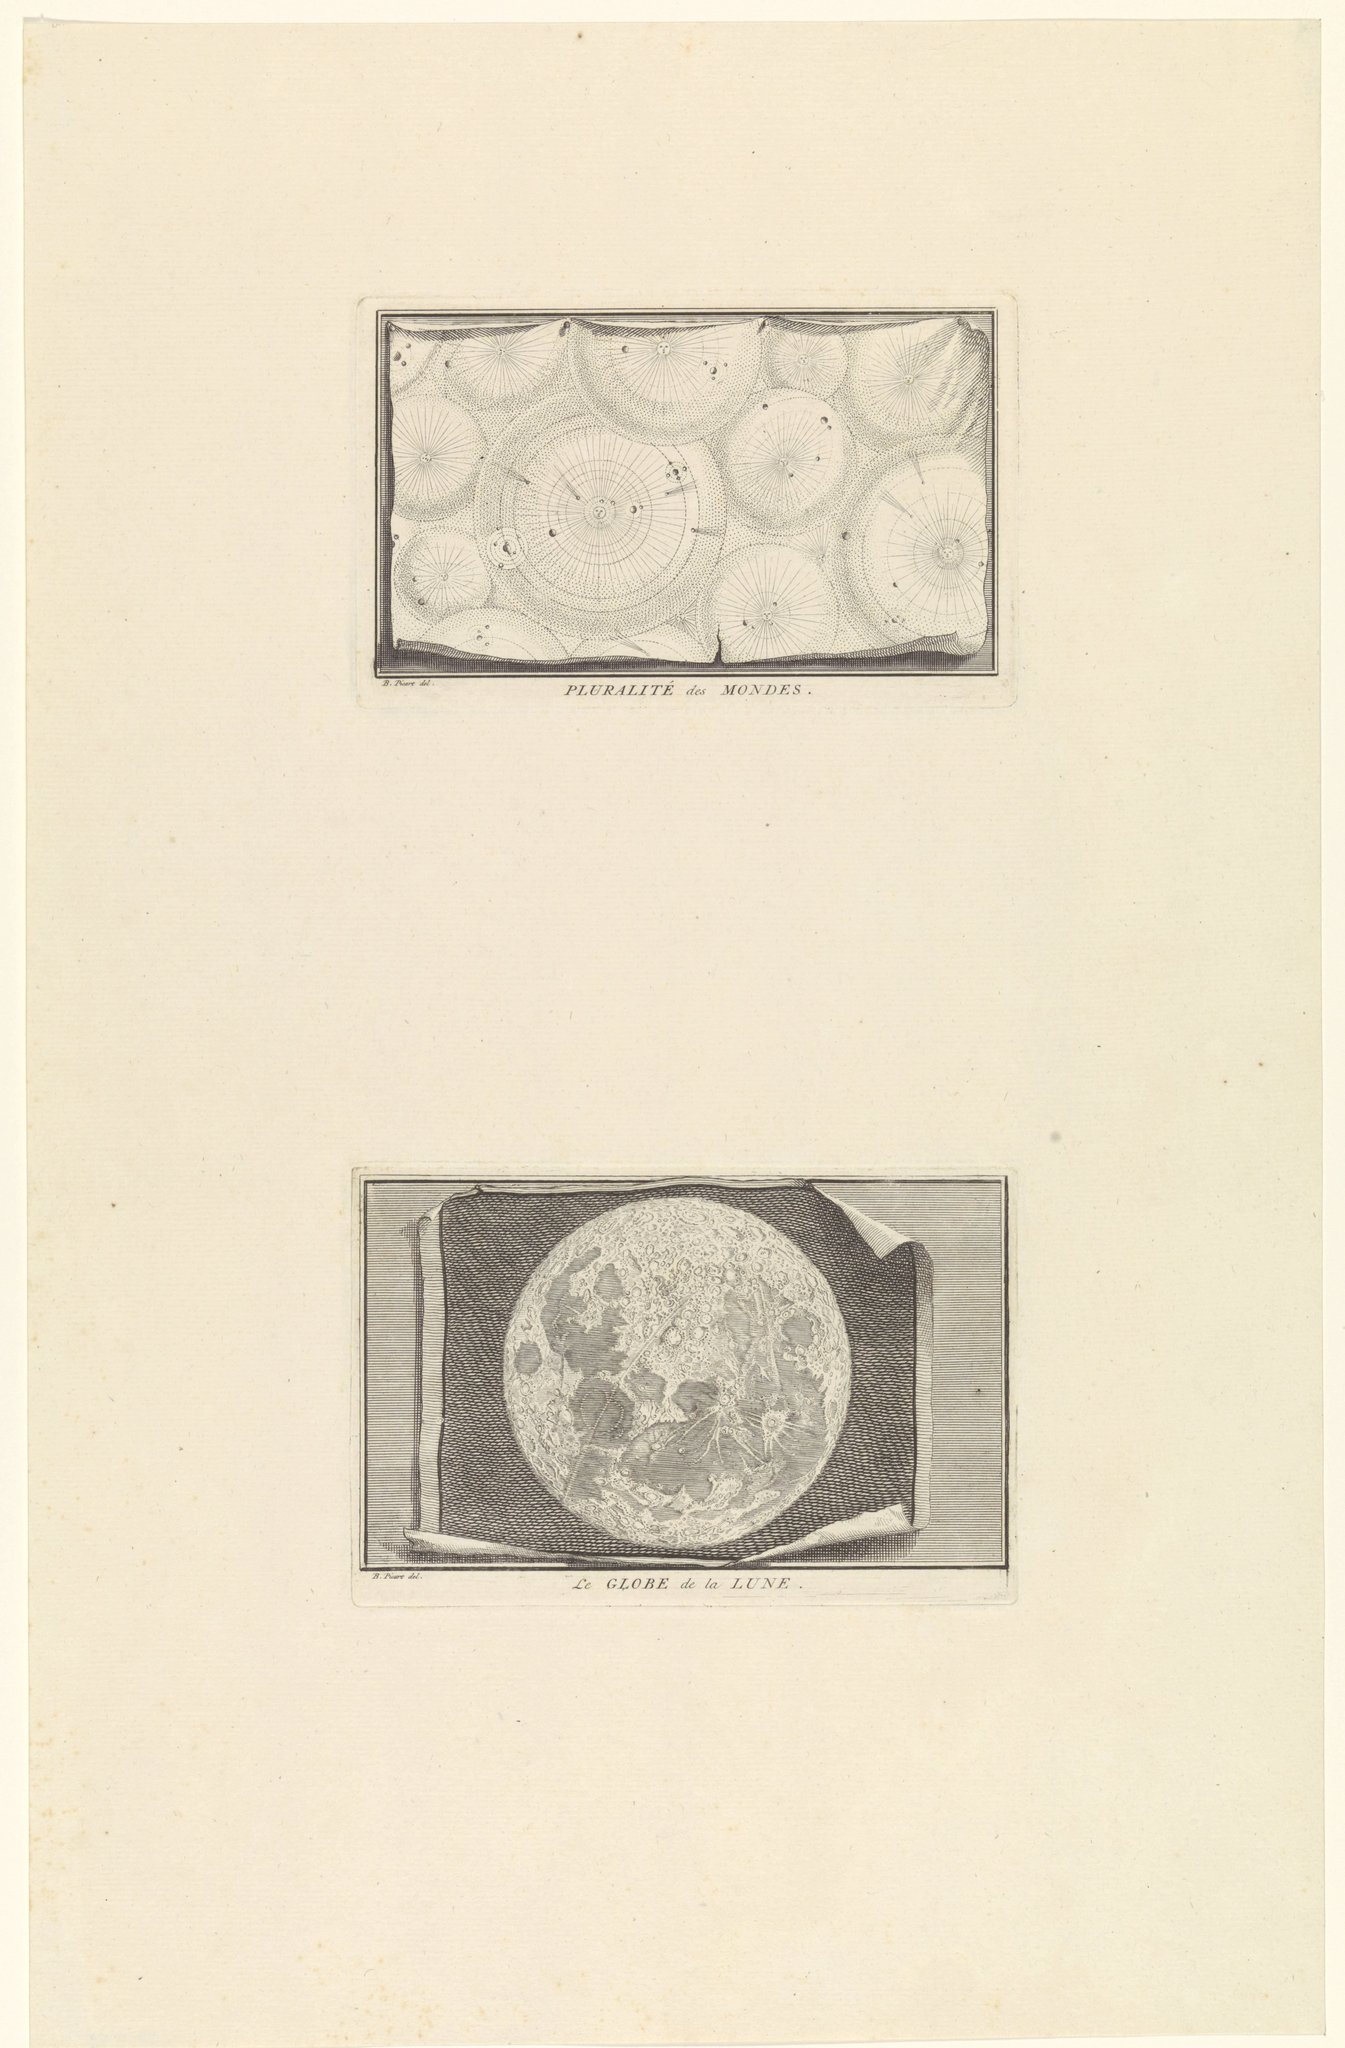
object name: print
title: Voorstellingen van het planetenstelsel en van de maan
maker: bernard picart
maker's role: draughtsman, print maker, publisher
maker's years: 1673-1733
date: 1683-1733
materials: paper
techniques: engraving, etching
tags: moon as celestial body, planets; planetary system, solar system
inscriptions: collector's mark: Lugt 2228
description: Onversneden blad met twee prenten. Boven: Een schematische weergave van het planetenstelsel. De aarde en planeten zijn voorgesteld als cirkels die rond elkaar draaien. Onder: Een gedetailleerde weergave van de maan.